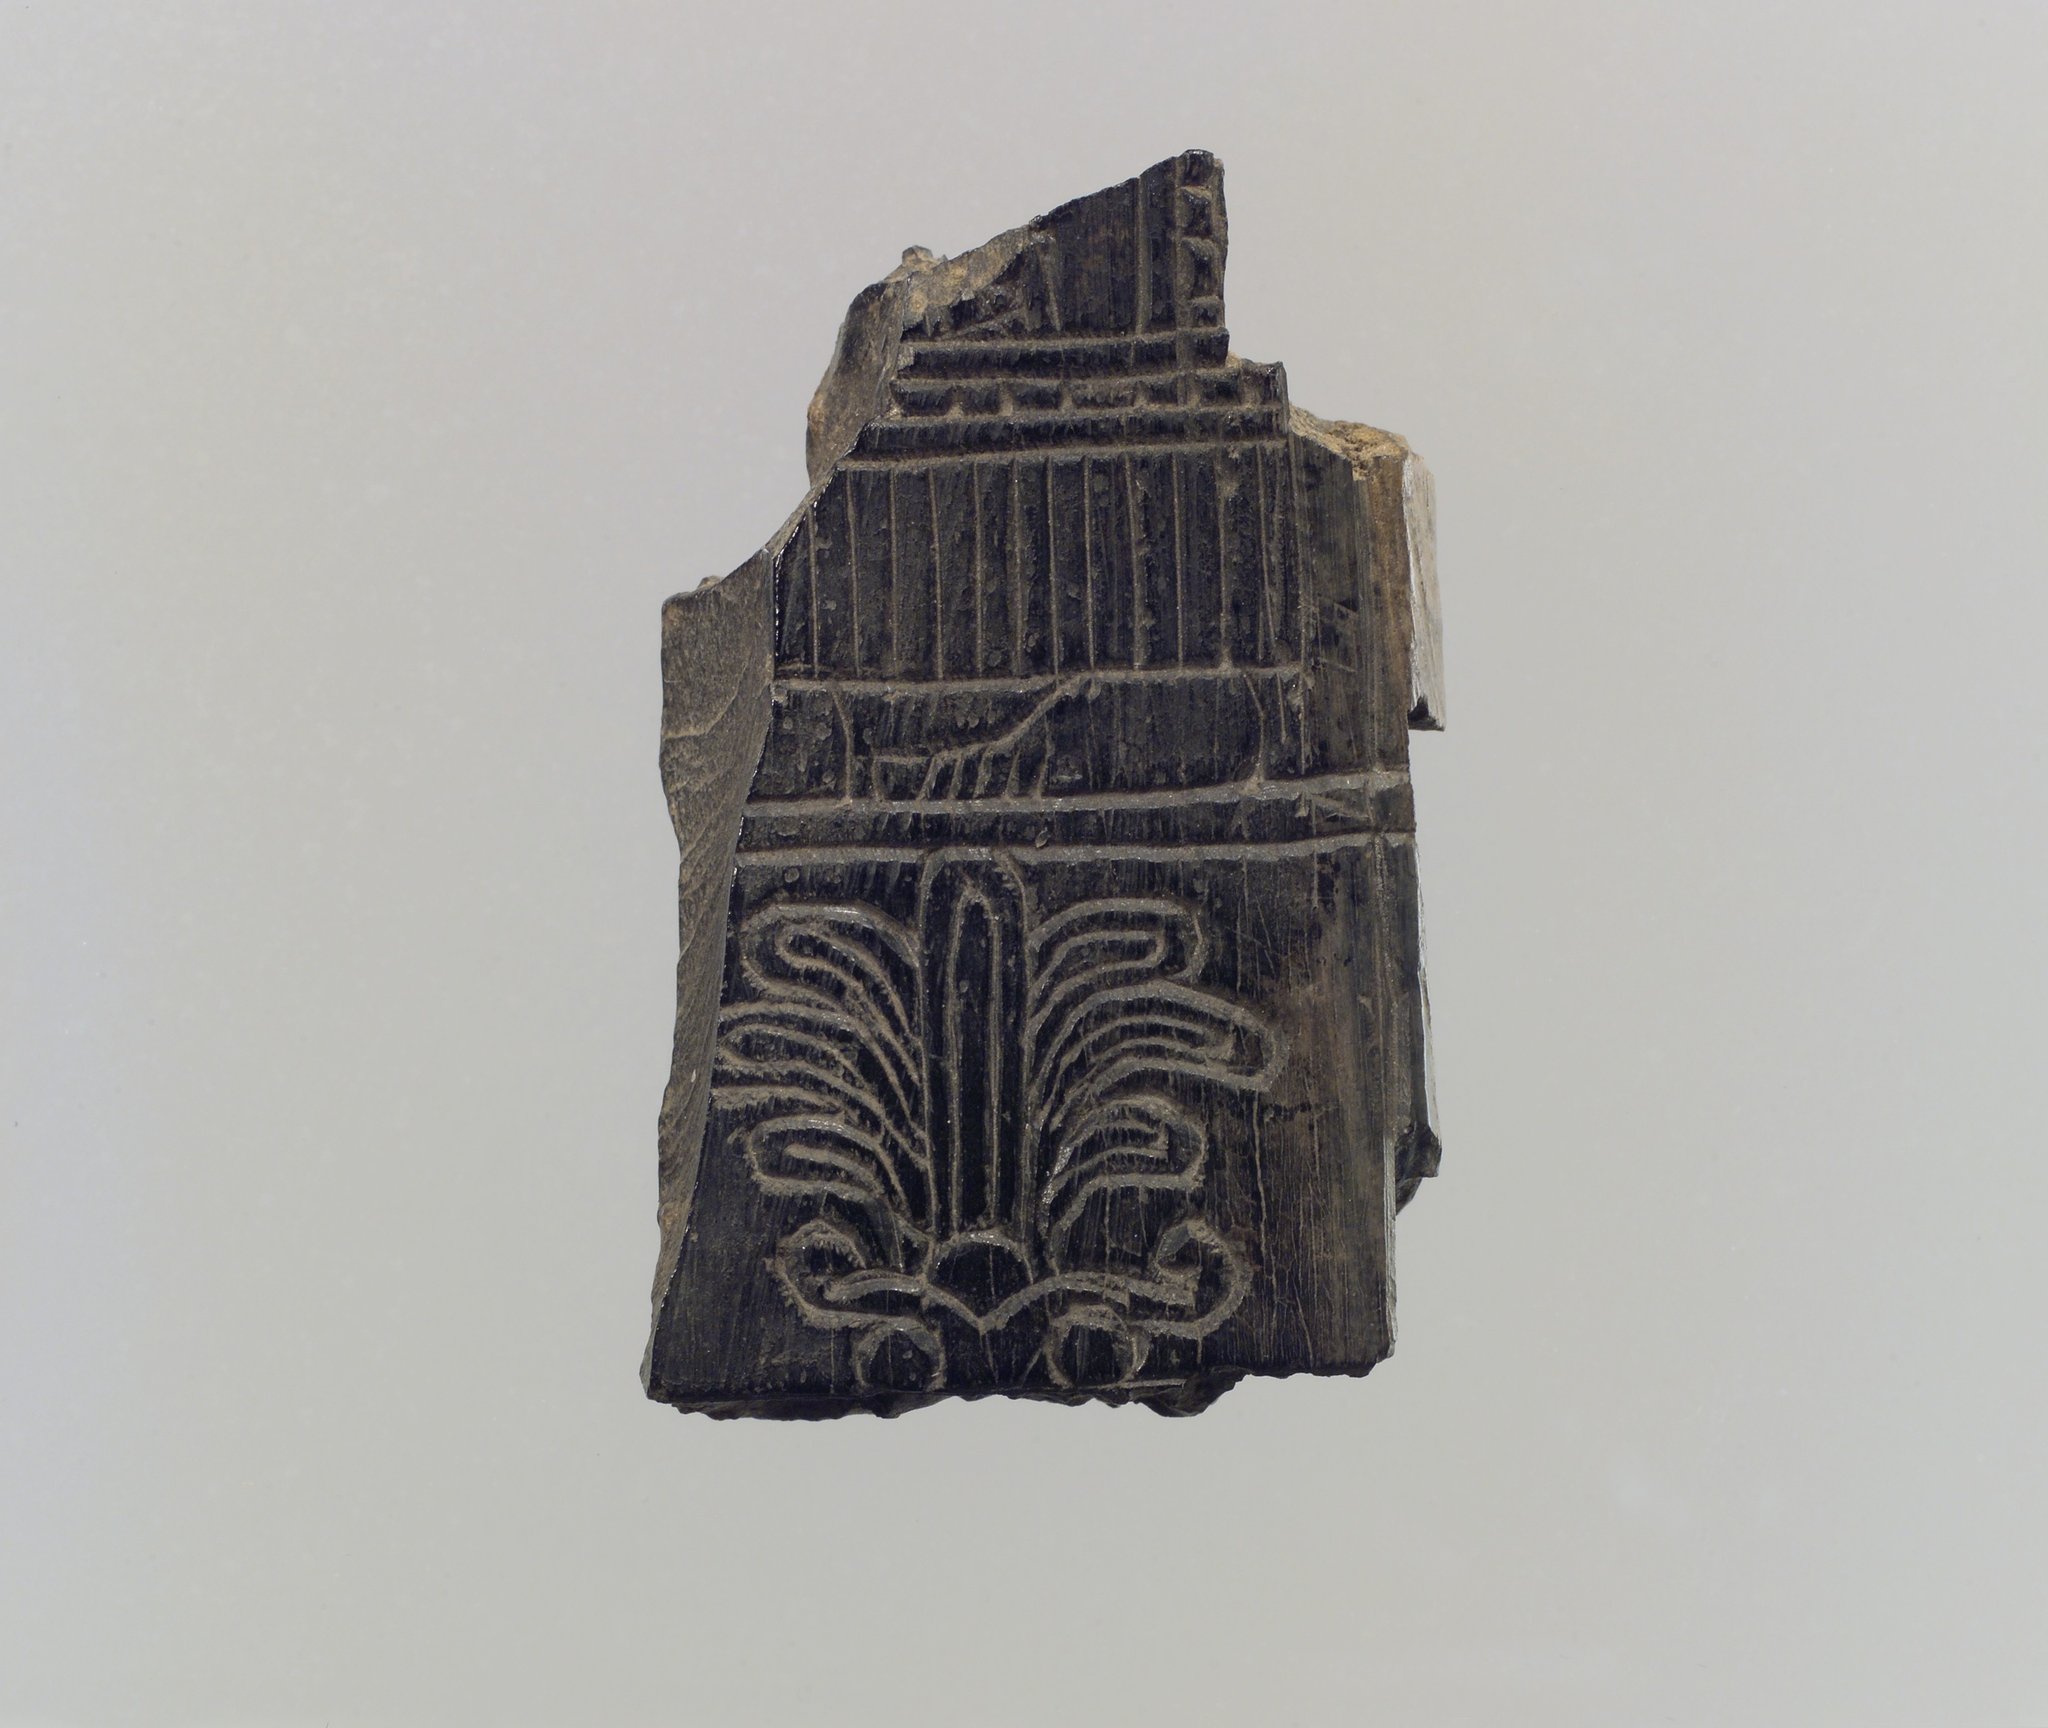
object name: relief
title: Plaque fragment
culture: assyrian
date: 900-701 BCE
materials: ivory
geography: mesopotamia